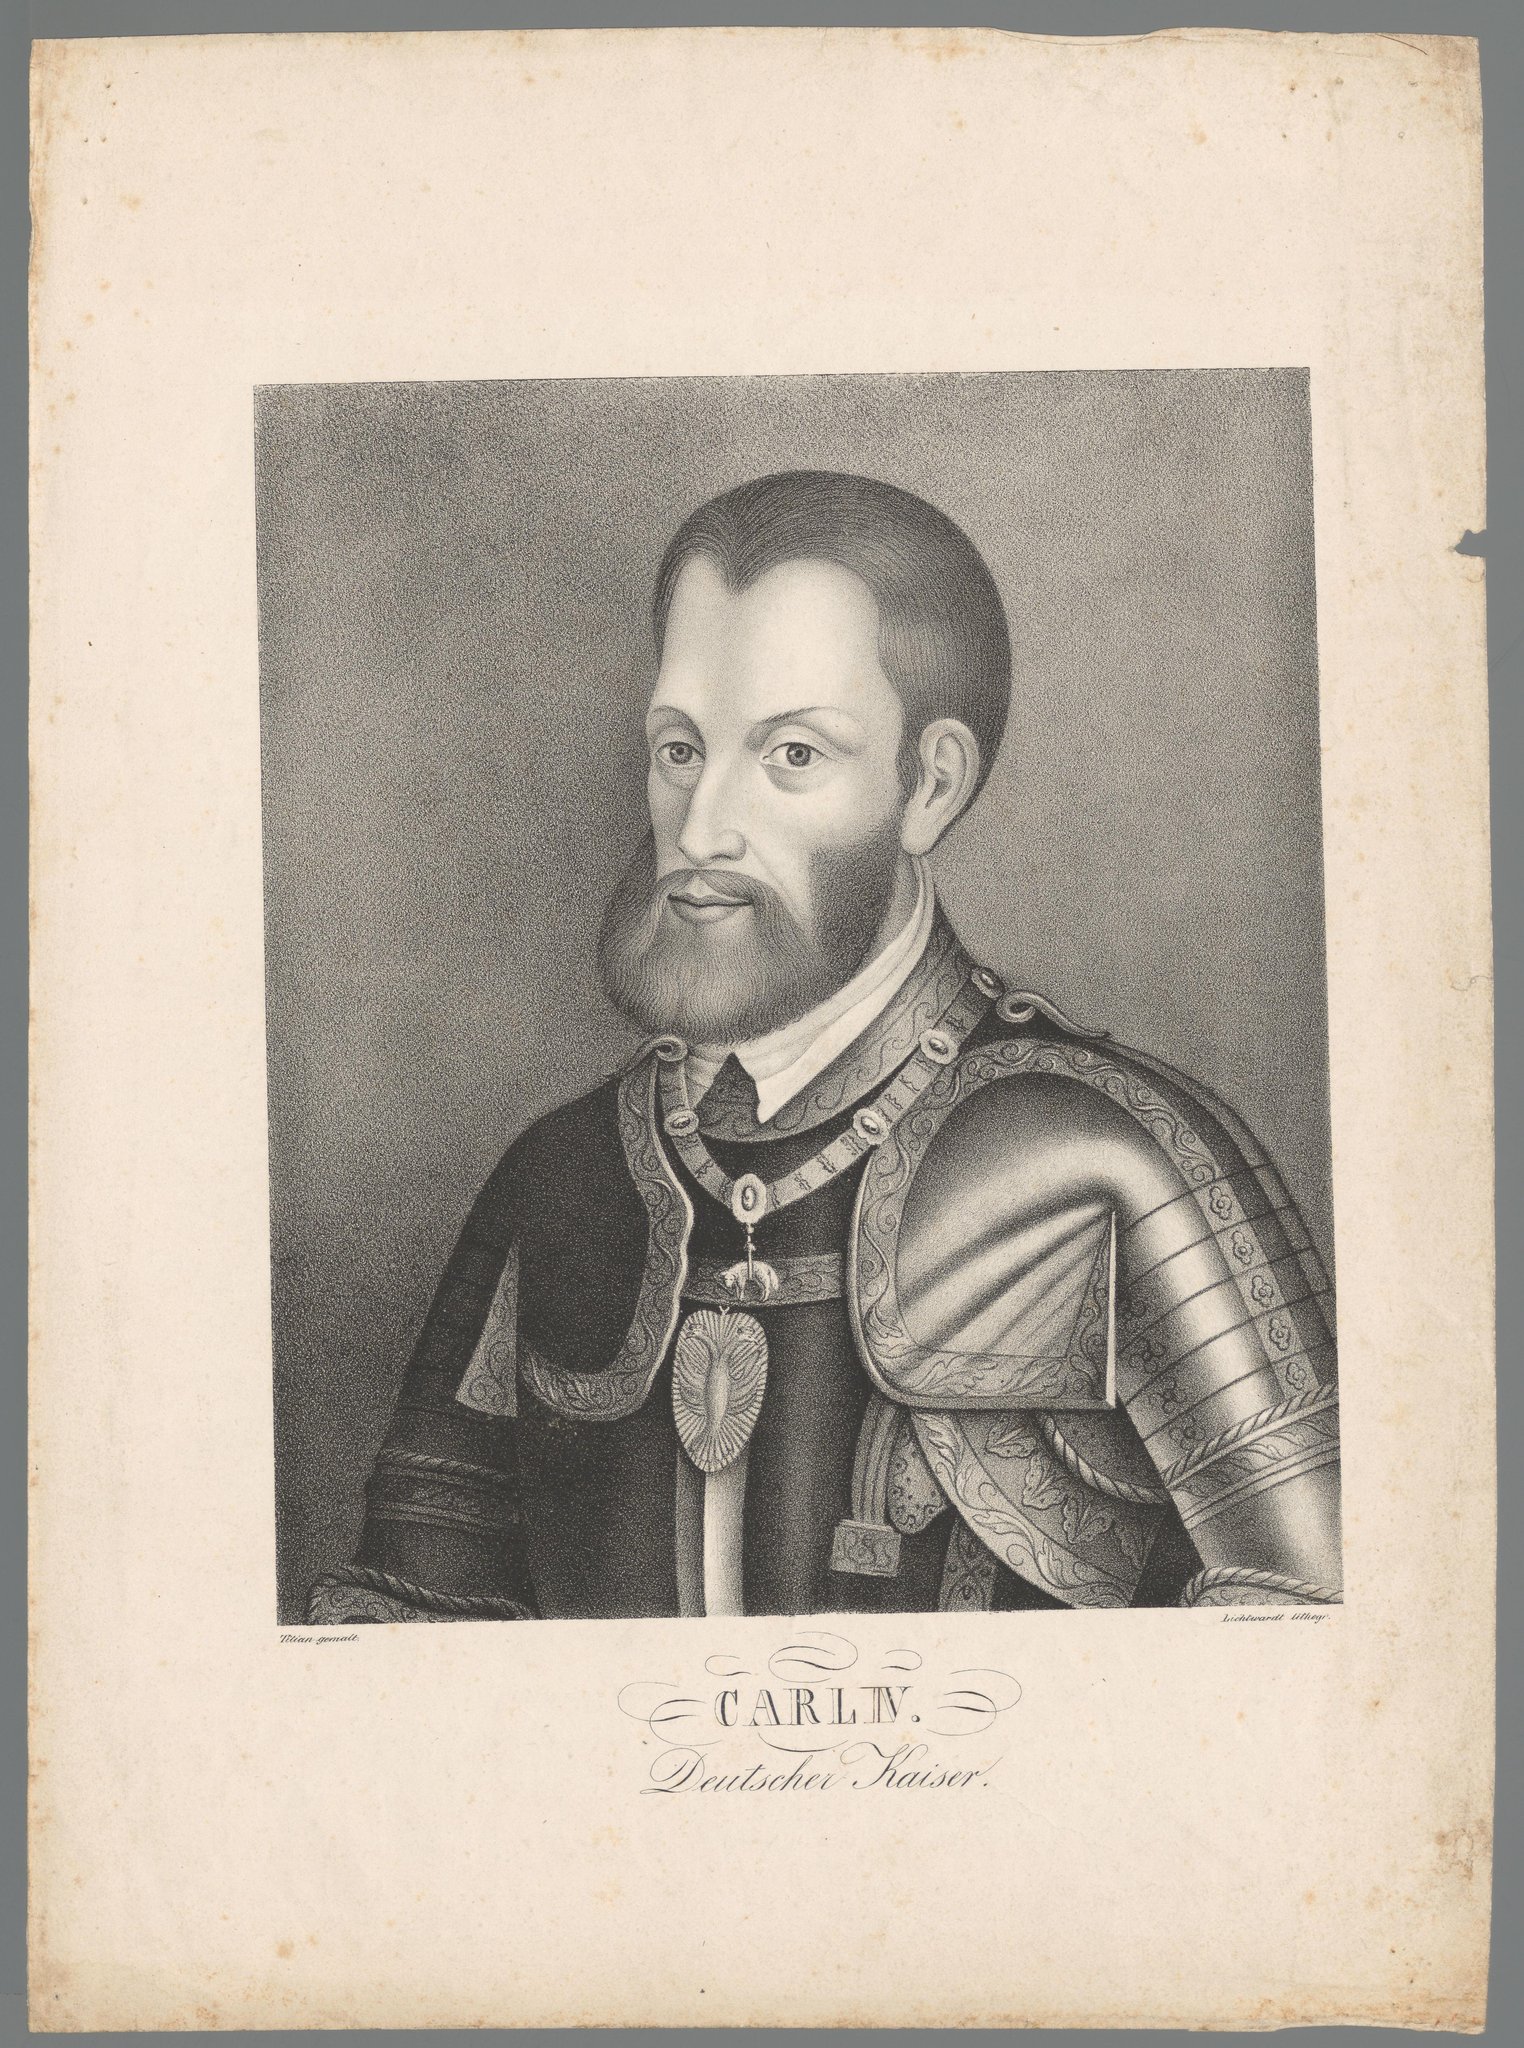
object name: print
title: Carl IV Deutscher Kaiser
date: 1820-1860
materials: paper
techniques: lithograph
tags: prague, historical persons, emperor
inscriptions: collector's mark: Lugt 2228